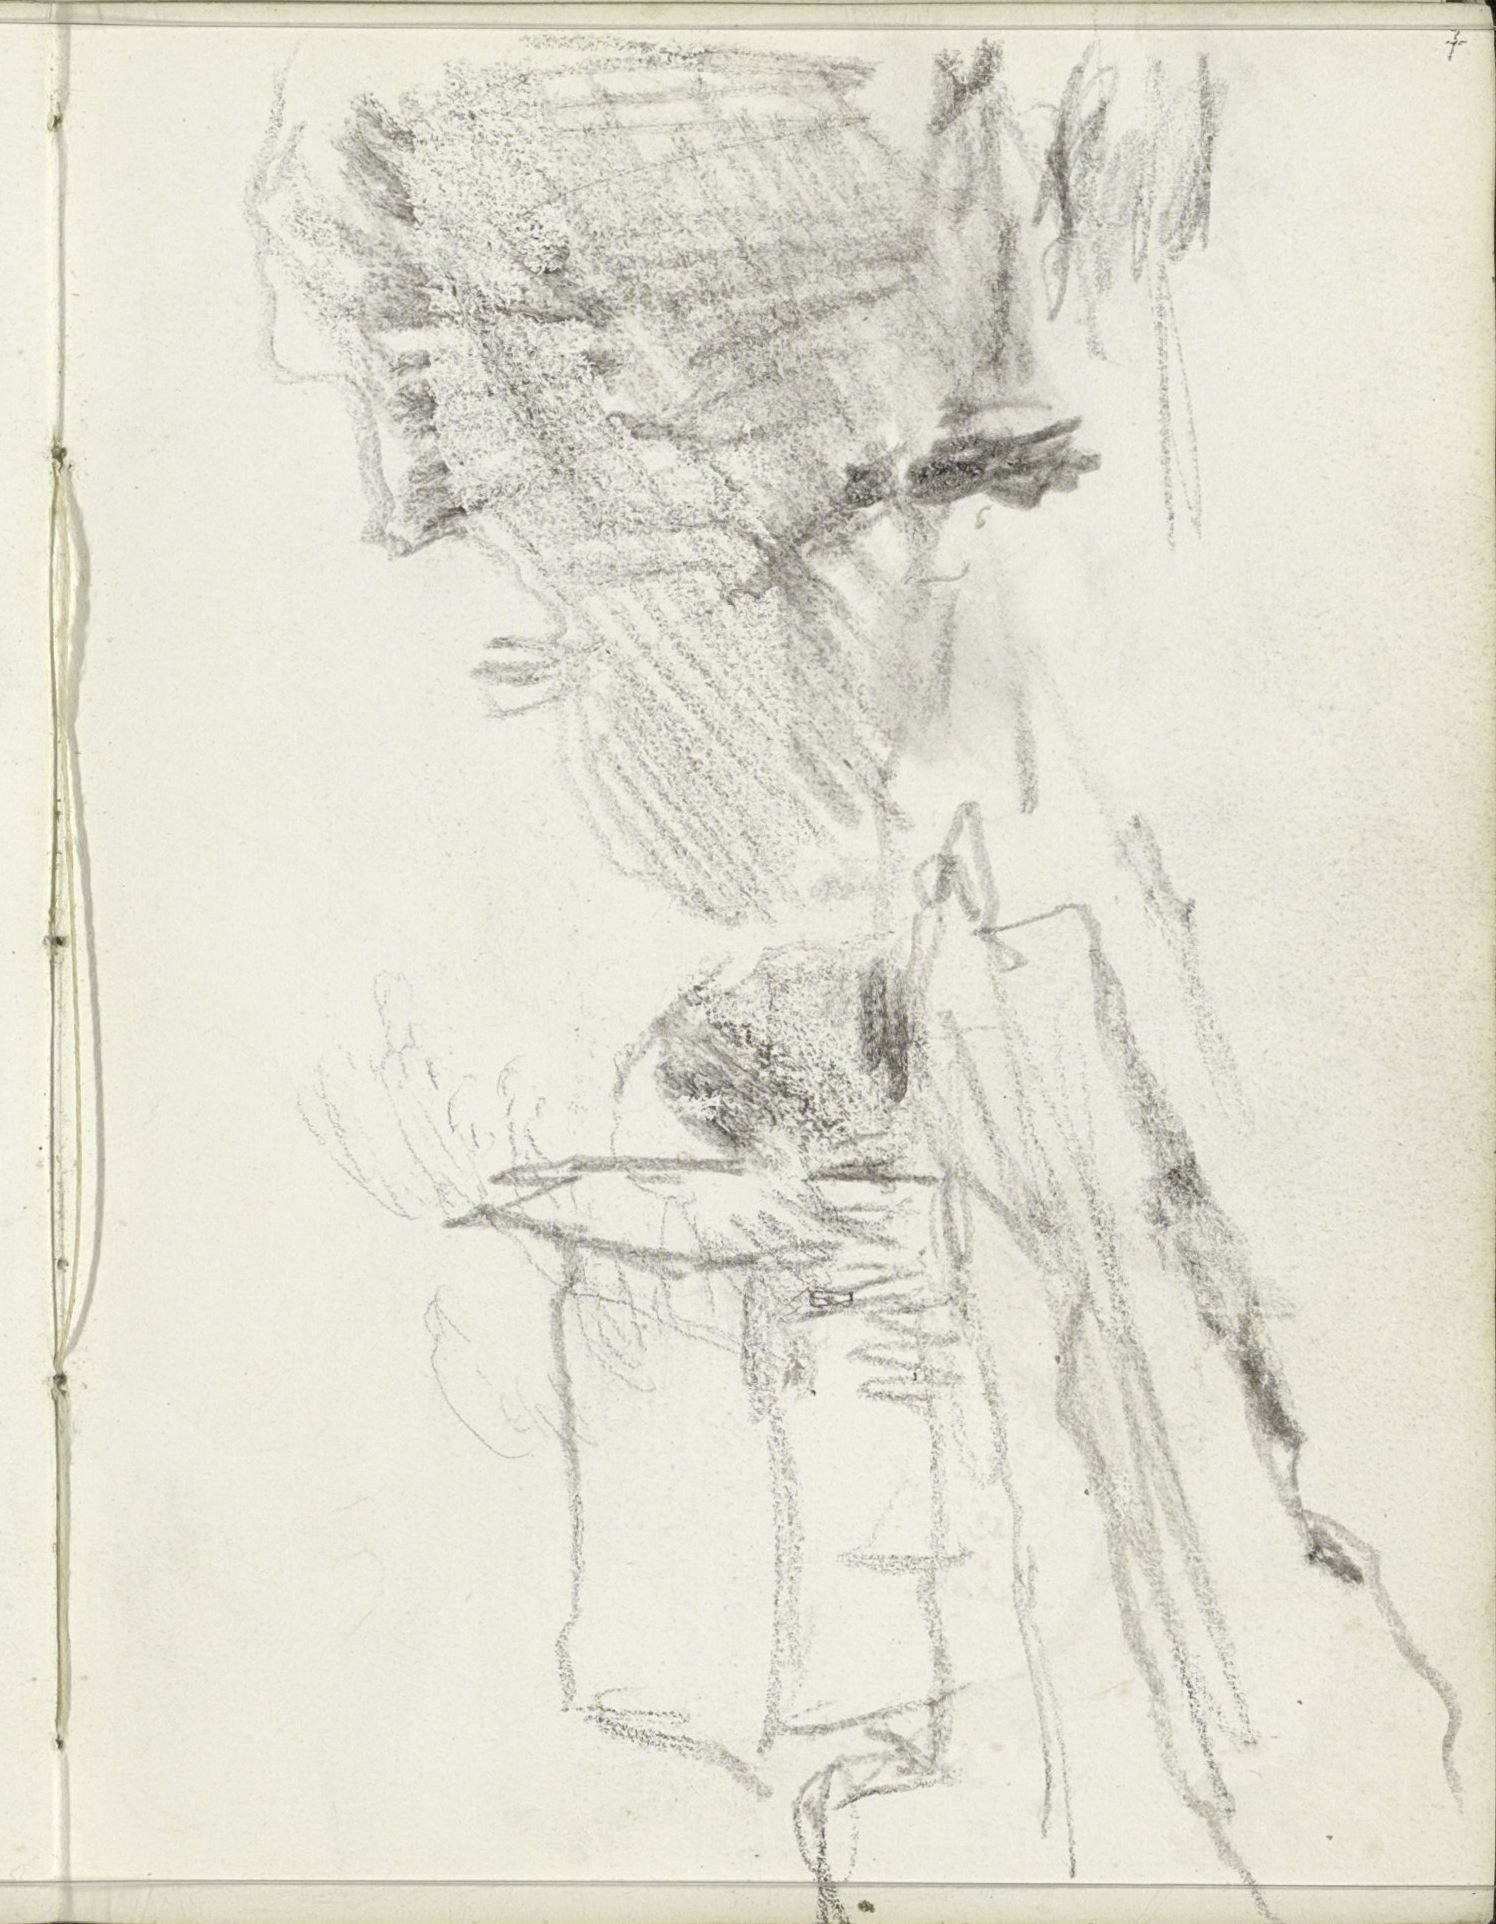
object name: sketchbook leaf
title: Figuur op een pad langs een plattelandswoning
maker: johan hendrik weissenbruch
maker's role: draughtsman, painter, print maker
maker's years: 1824-1903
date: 1834-1903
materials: chalk, paper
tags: road, path, cottage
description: Blad 7 recto uit een schetsboek met 34 bladen.